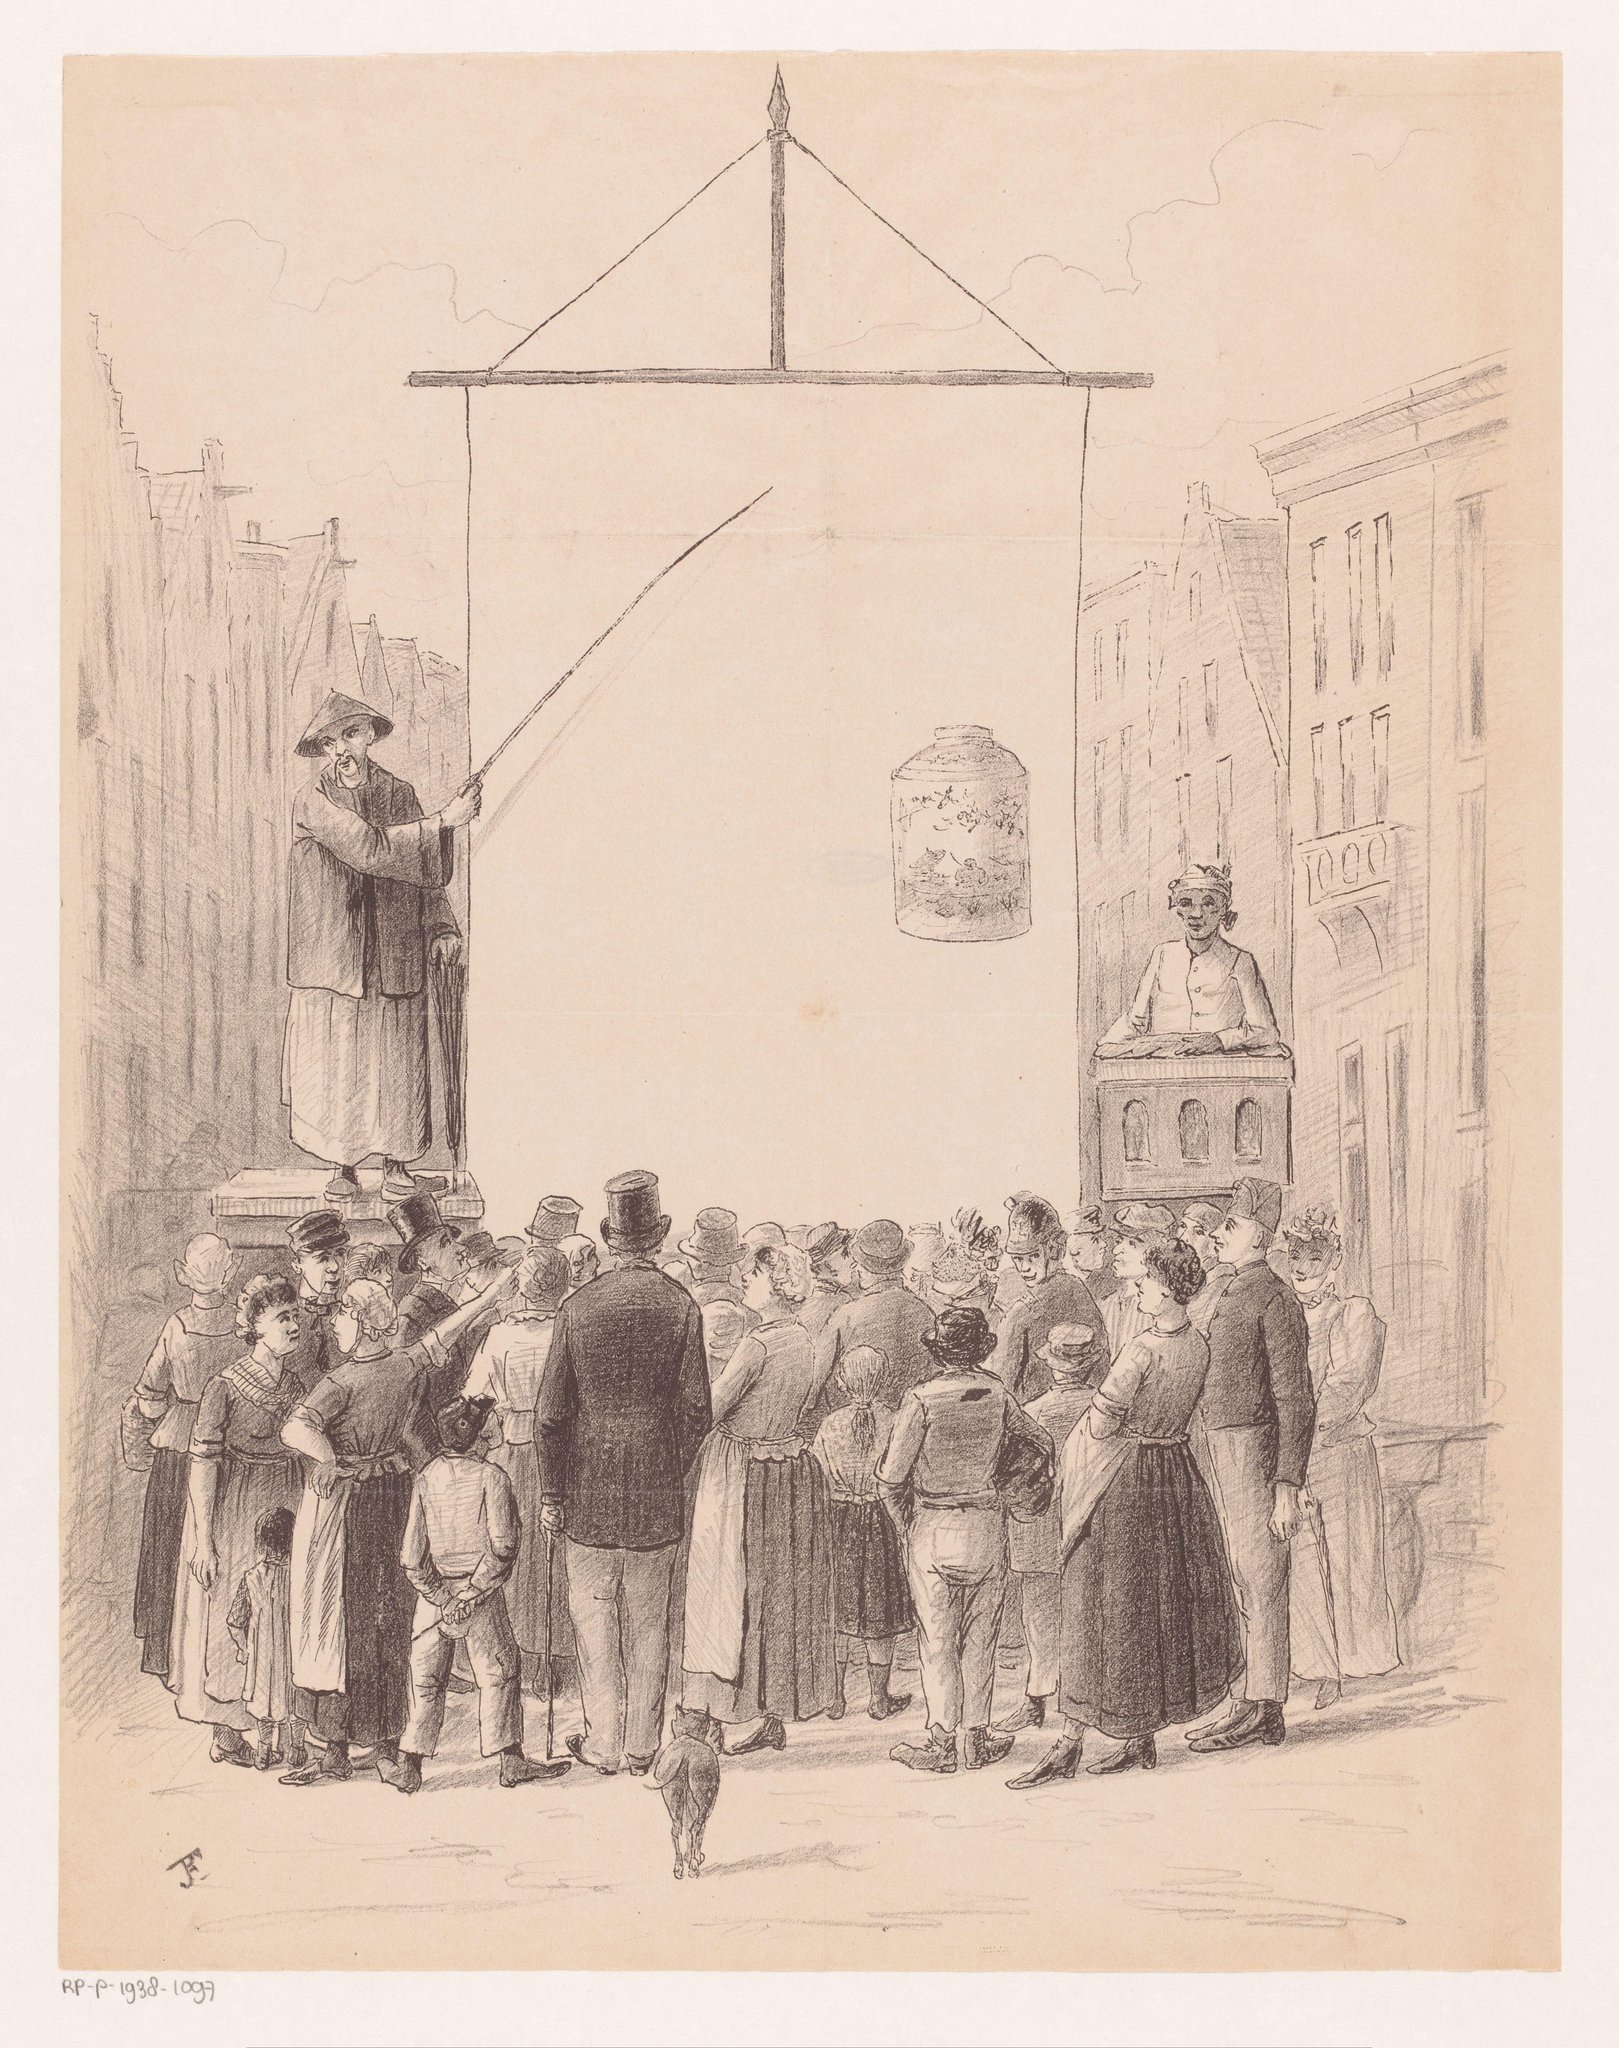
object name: print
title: Theaterscène op straat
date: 1883-1930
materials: paper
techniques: lithograph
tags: chinese, theatre, theatrical performance, shadow-play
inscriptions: collector's mark: Lugt 2760, collector's mark: Lugt 2228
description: Links en rechts van een groot wit doek staan een Chinese en Javaanse man. Op het doek is een oosterse pot afgebeeld. Voor het doek heeft een groep mannen, vrouwen en kinderen verzameld. Sommige van hen dragen maskers. Mogelijk is hier een zogenaamd schimmenspel afgebeeld waarbij met bewegende schaduwen een voorstelling wordt opgevoerd.